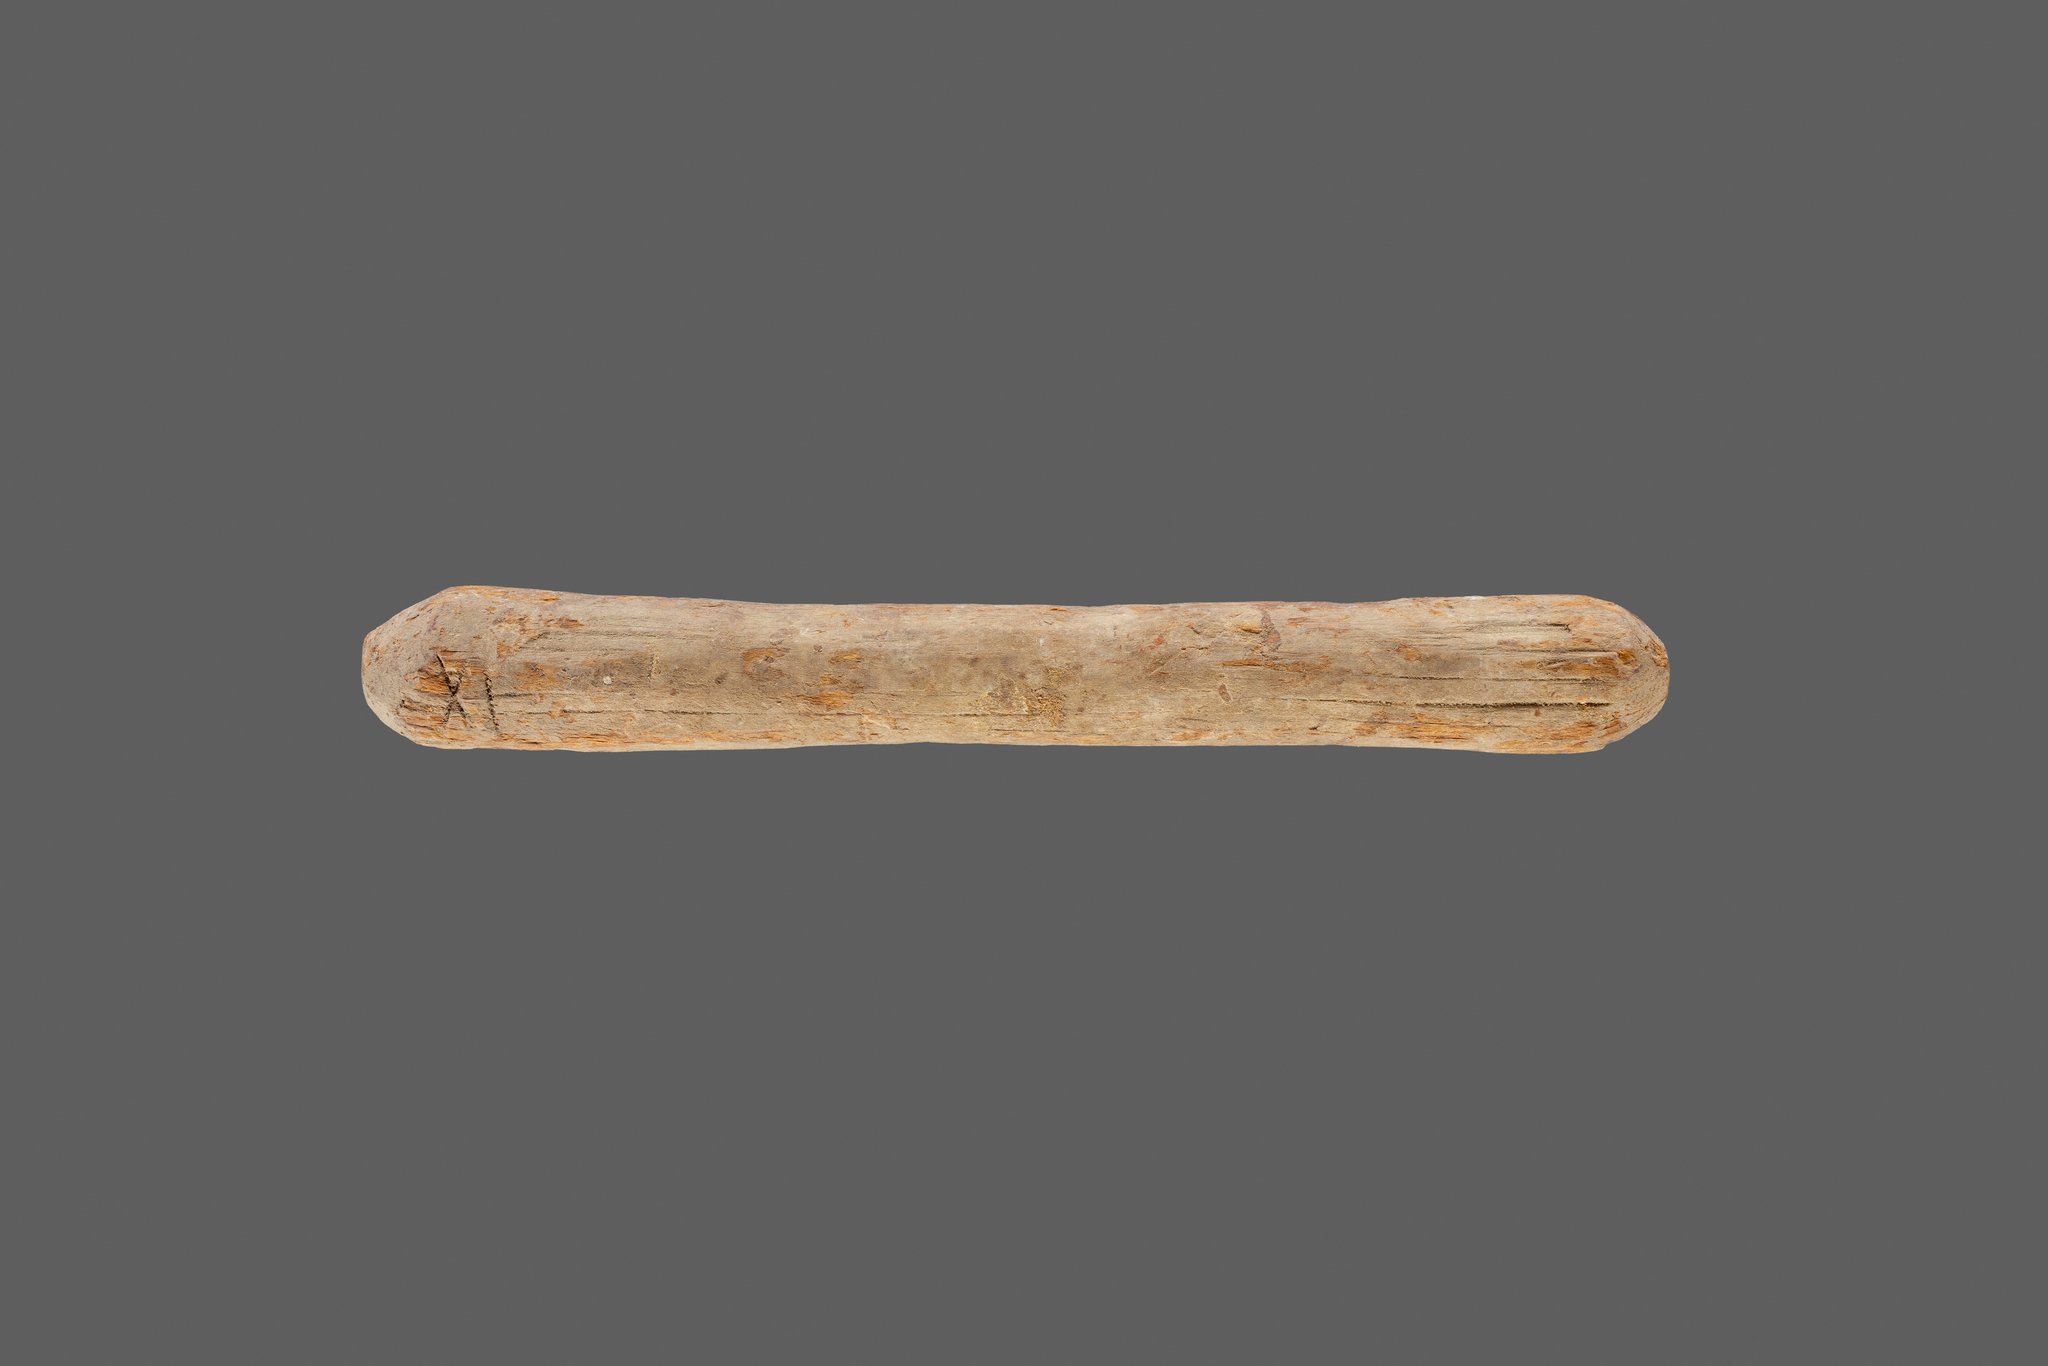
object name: coffin rope handle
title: Handle for rope for lowering coffin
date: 1070-945 BCE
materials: wood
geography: egypt